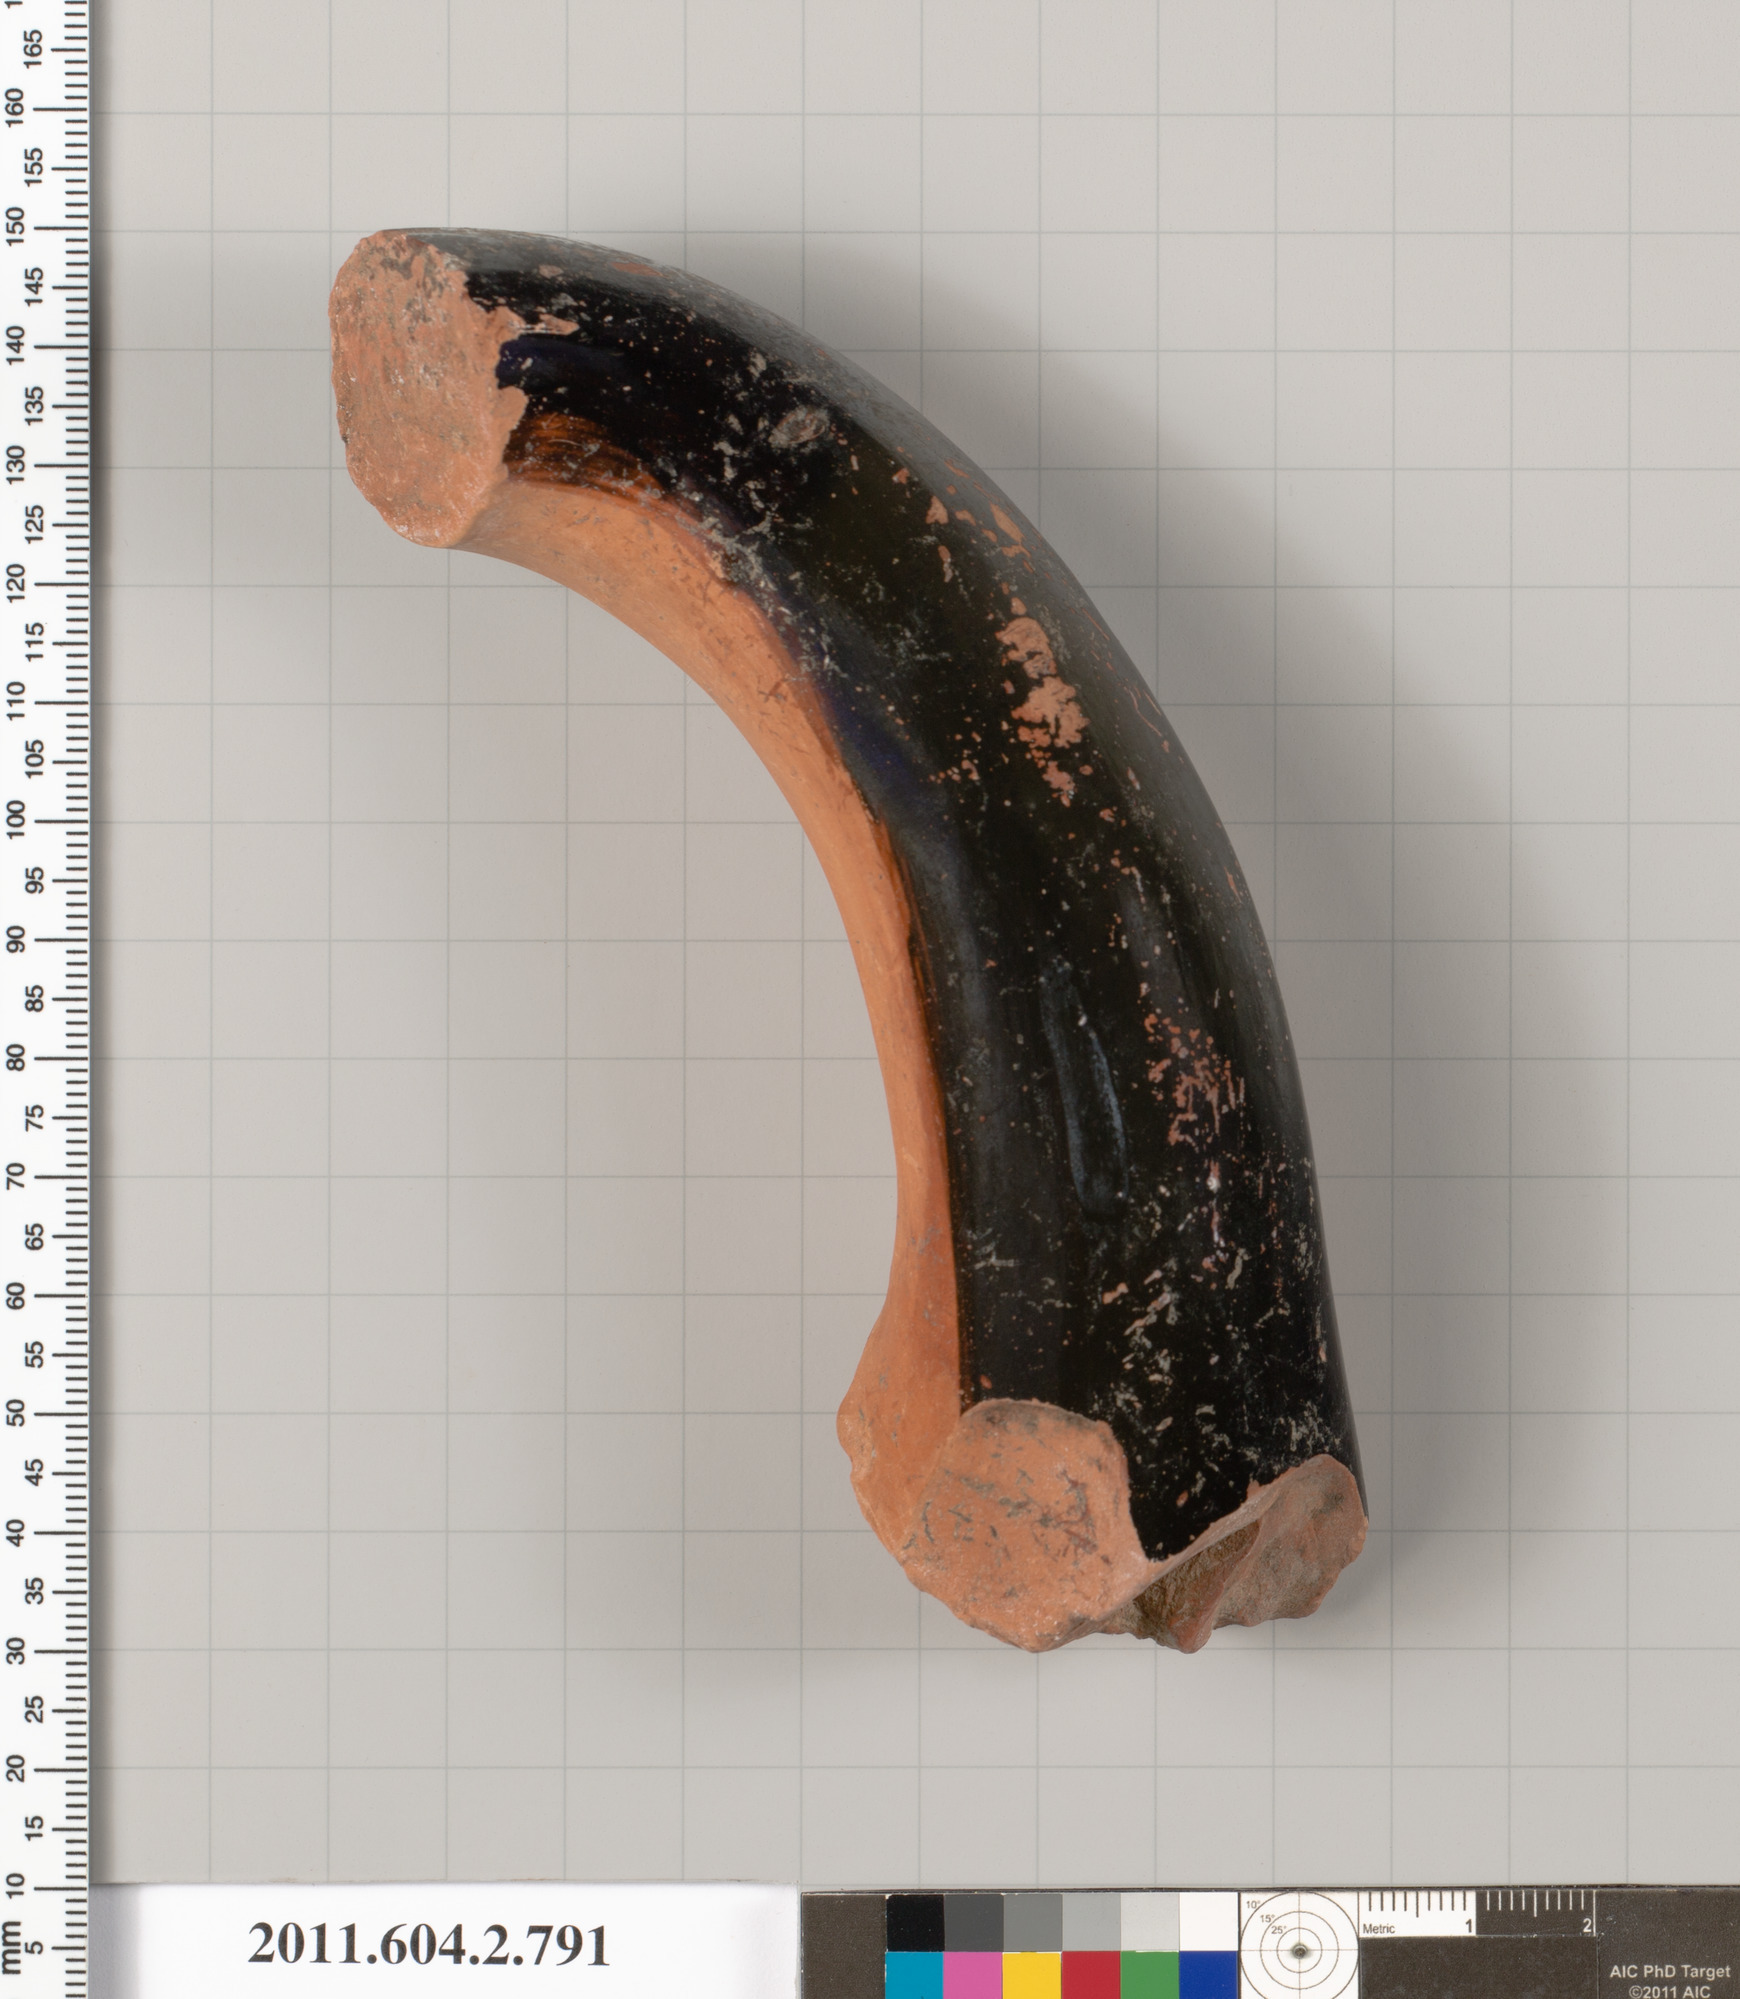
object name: calyx krater fragment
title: Terracotta fragment of a calyx-krater (bowl for mixing wine and water)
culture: greek, attic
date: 475-451 BCE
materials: terracotta